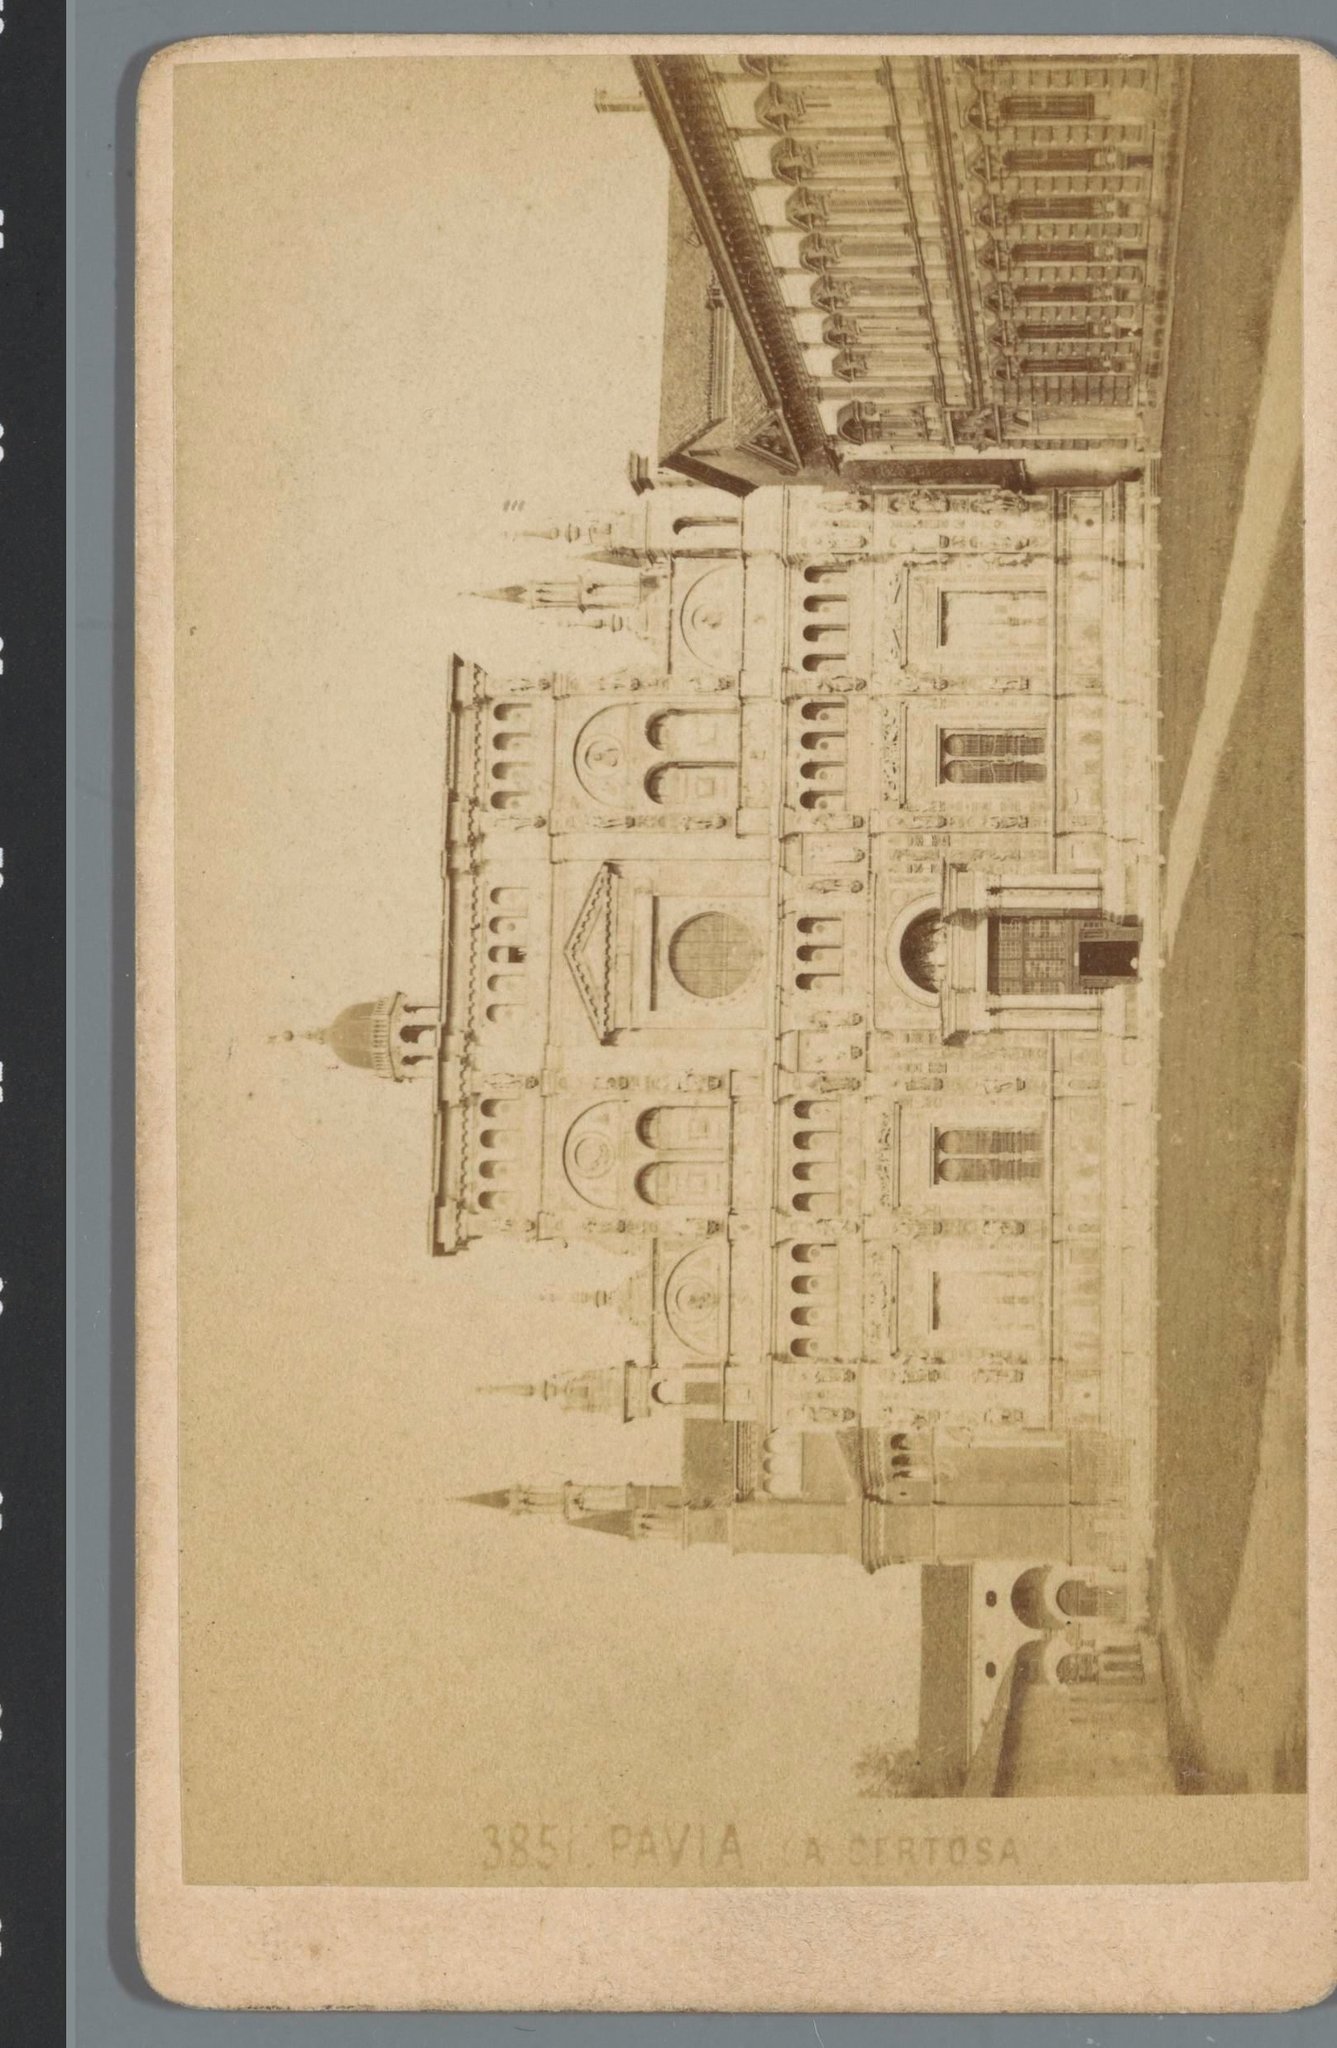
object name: carte de visite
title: Pavia, la Certosa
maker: giacomo brogi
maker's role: fotograaf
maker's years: 1822-1881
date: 1865-1881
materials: cardboard, paper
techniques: albumen print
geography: certosa di pavia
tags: parts of church exterior and annexes: west façade, abbey, monastery, convent ~ roman catholic church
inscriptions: number: ‘3851’, inscription: ‘Giacomo Brodi/ fotografo editore/ 15, Lung'arno delle grazie/ Firenze/ Estese collezioni/ di Vedute d'Italia, d'Egitto e di Palestina/ edite in diversi formati./ Fotografie di Disegni e Pitture riprodotte dagli originali./ Grandissimi panorama di un sol pezzo./ Grandiosa collezione delle principali dipinture/ delle Gallerie d'Europa.’